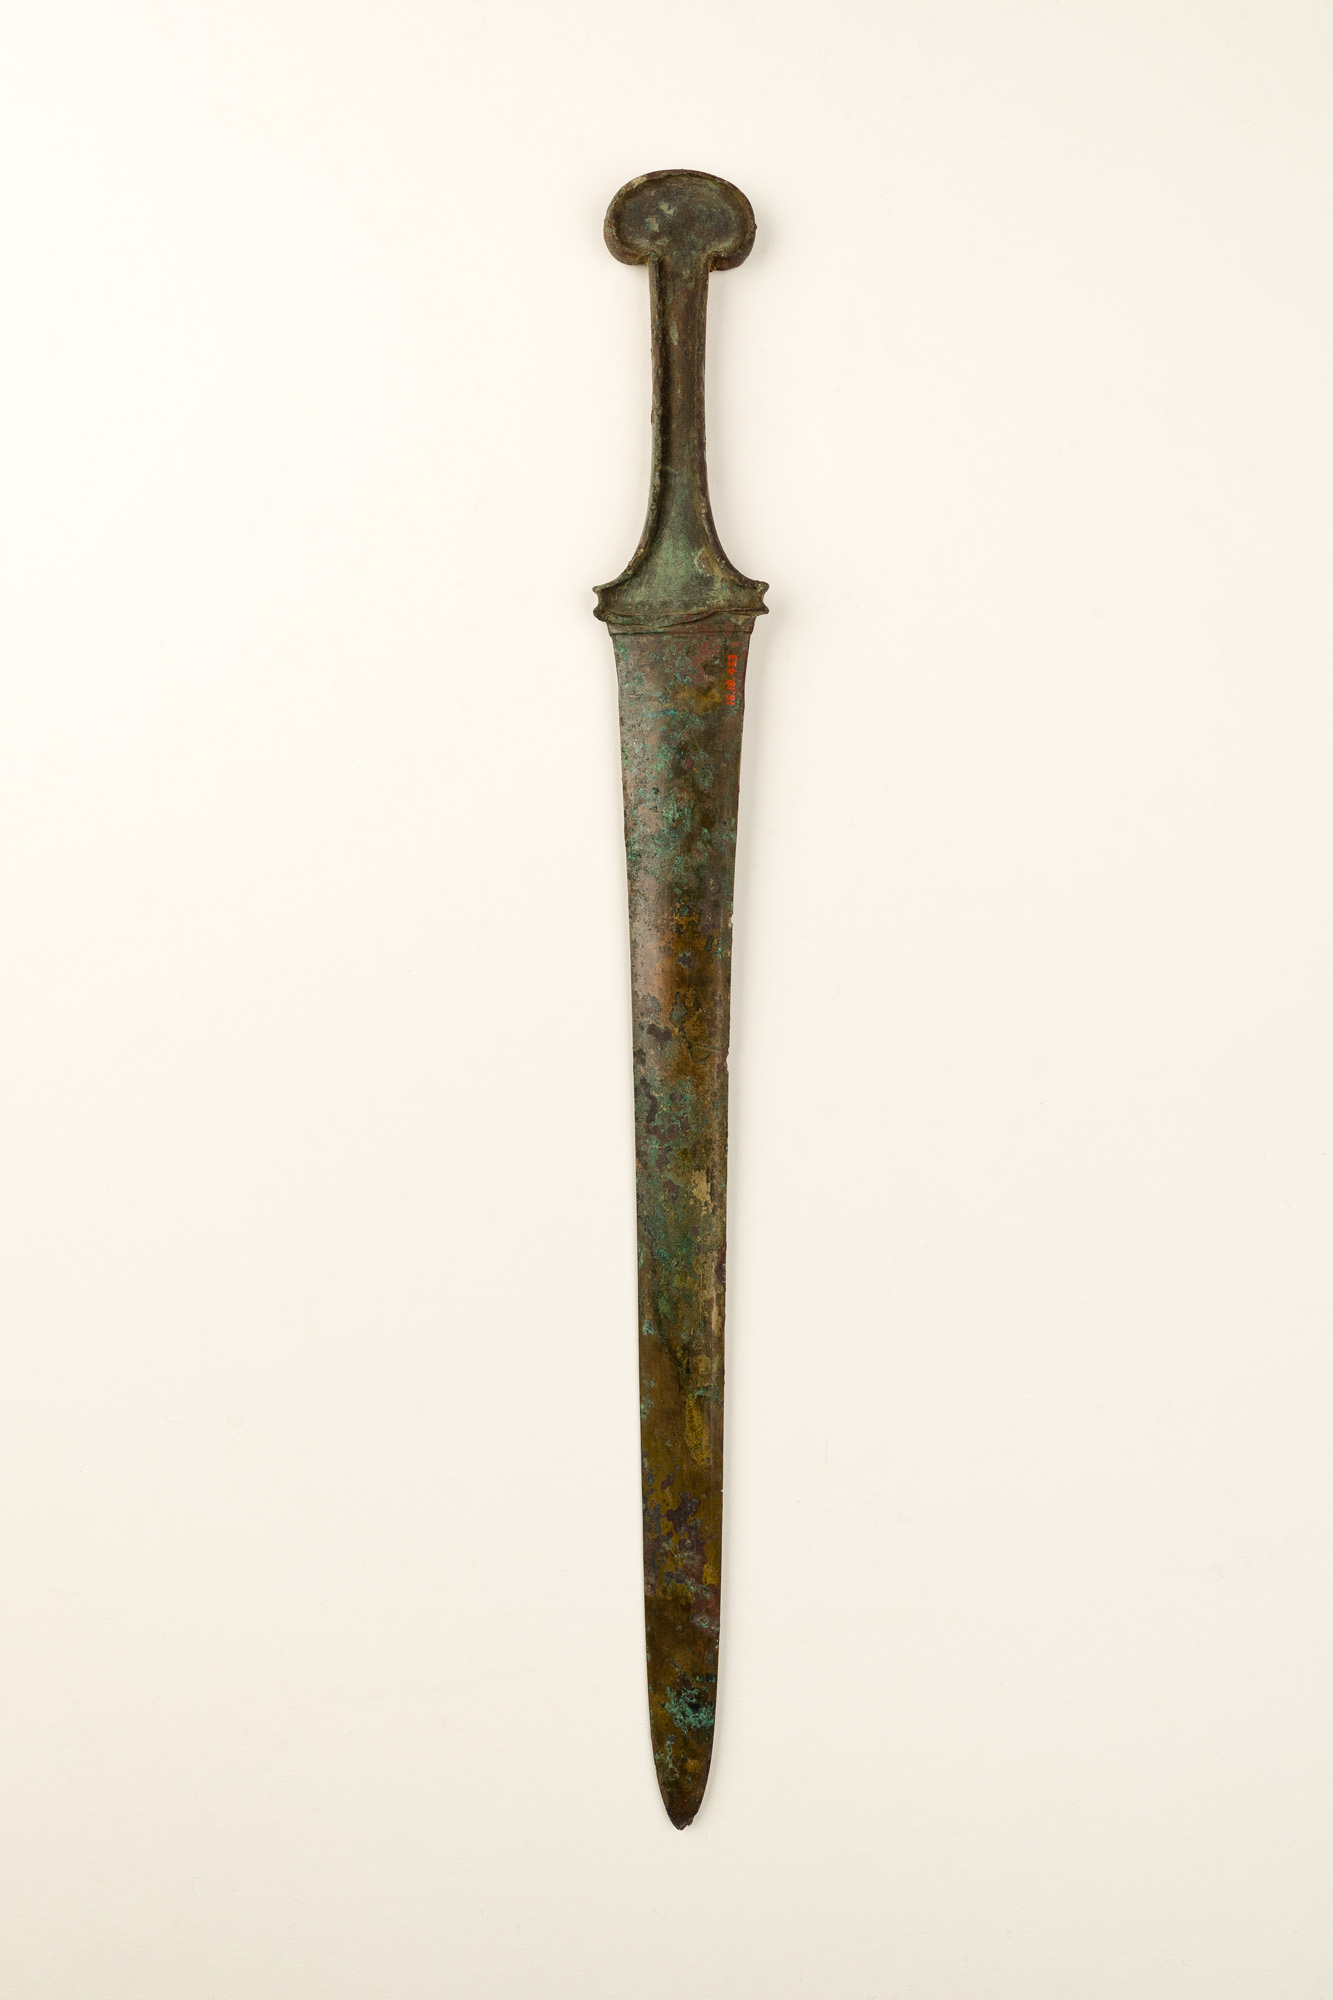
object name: sword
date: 1550-1458 BCE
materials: copper alloy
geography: egypt